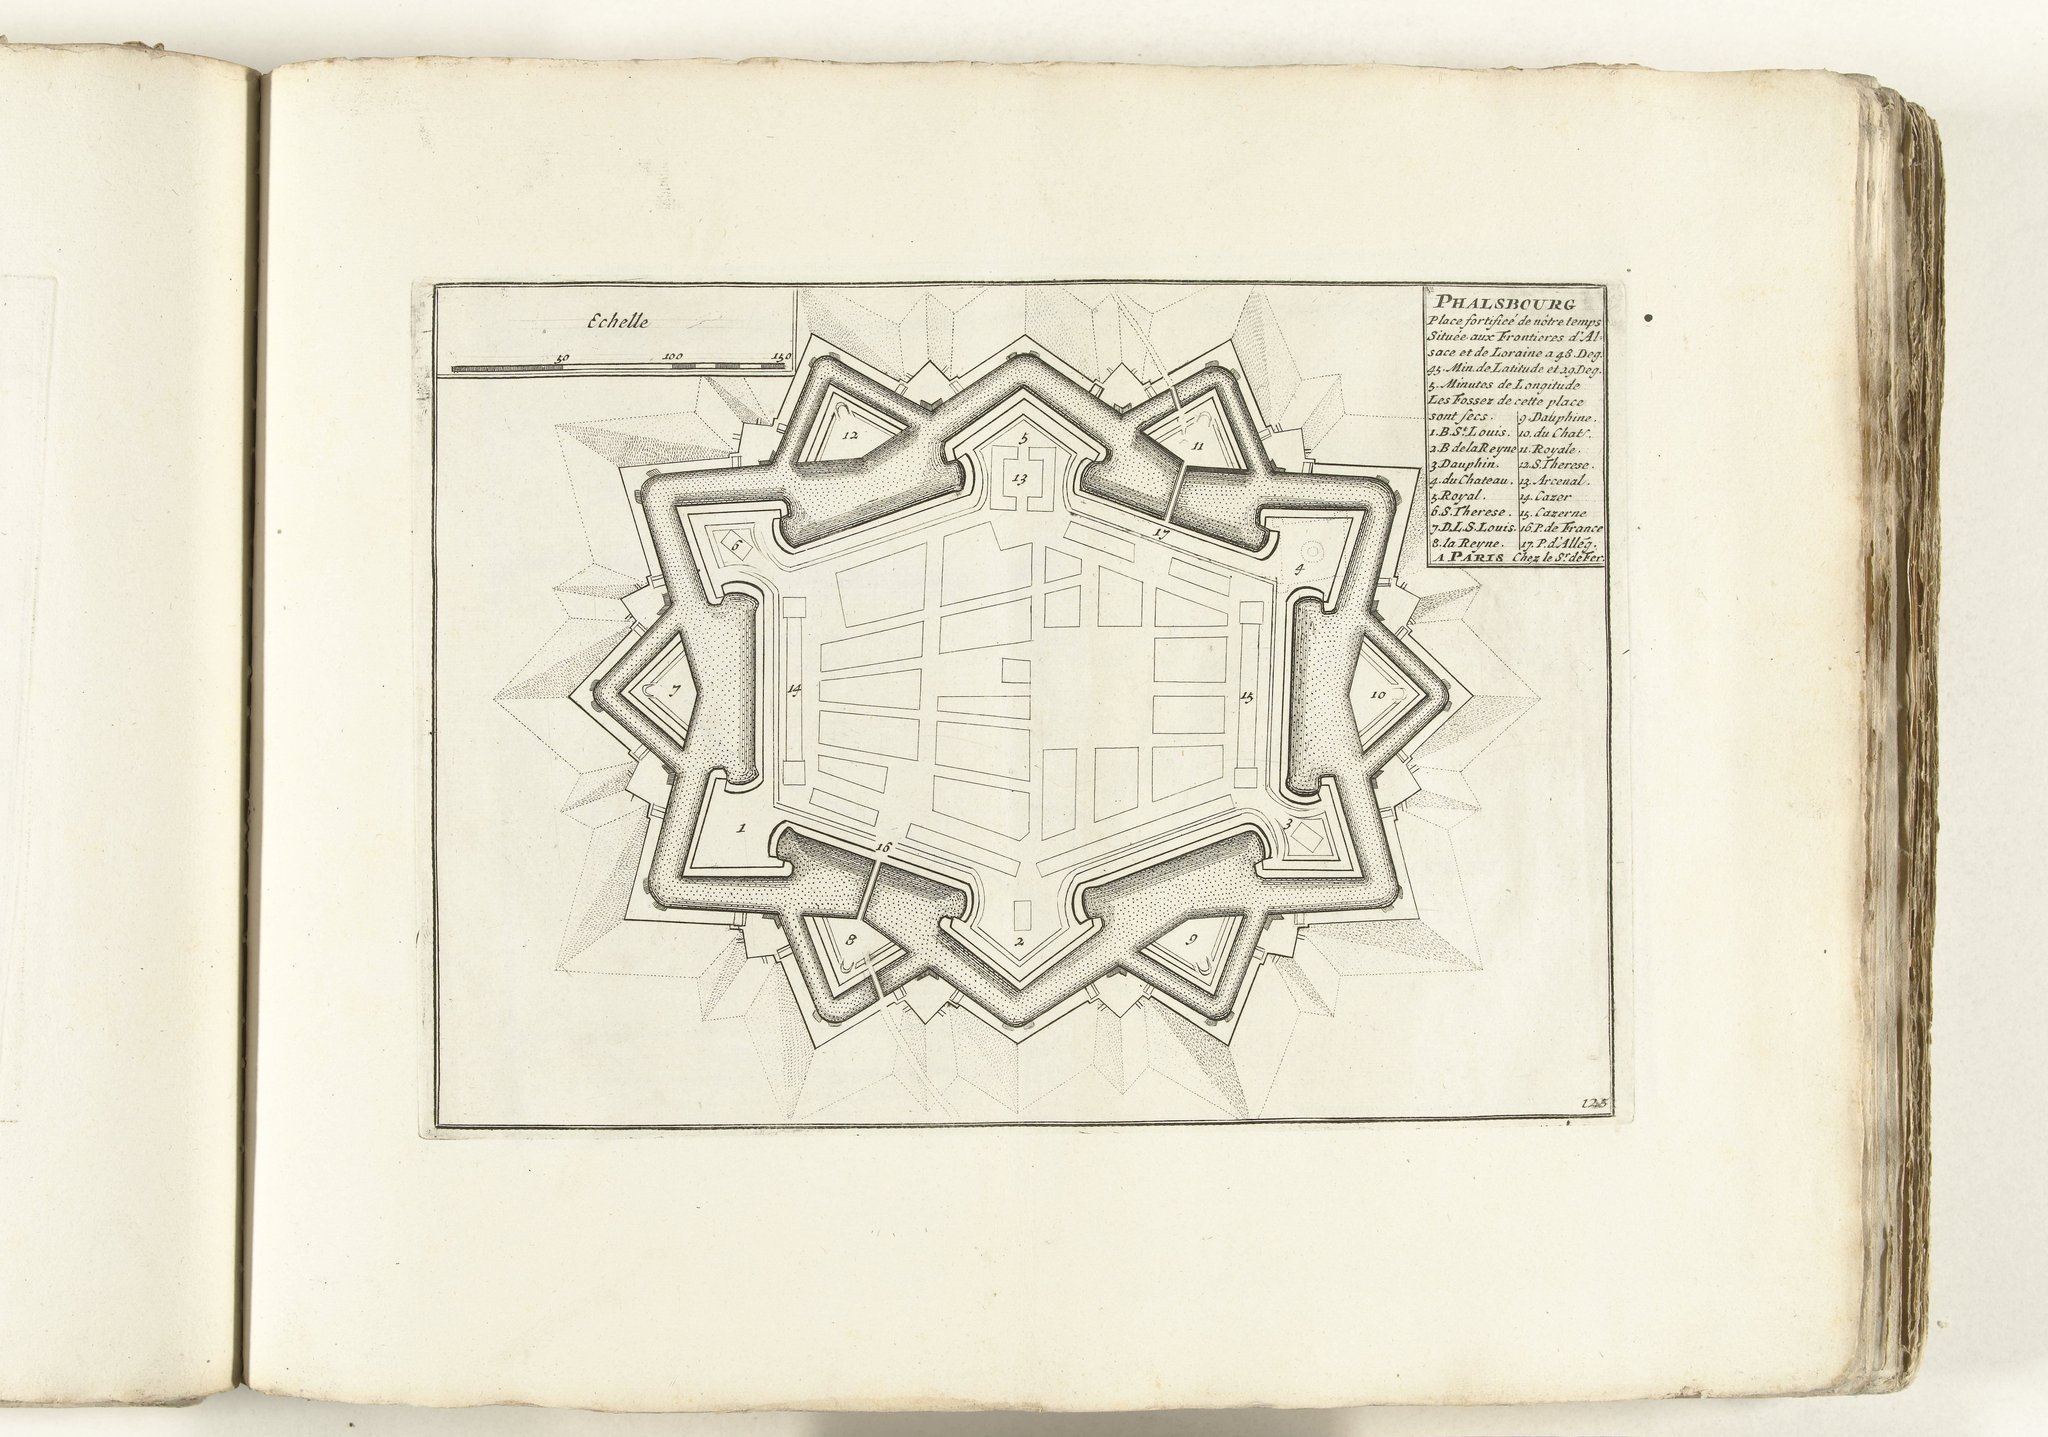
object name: print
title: Phalsbourg Place fortifiée de notre temps (...)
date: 1702-1703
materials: paper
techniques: etching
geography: northern netherlands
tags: fortress, maps of cities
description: Plattegrond van de versterkingen om de stad Phalsbourg. Plaat nr. 125 in het prentwerk bestaande in totaal uit 276 genummerde platen van vermaarde sterke steden en vestingen in het kader van de Spaanse Successieoorlog. Voor het merendeel zijn deze platen gekopieerd naar de anonieme Franse platen: in Les forces de l'Europe en in: Le theatre de la guerre, dans les Pays-Bas, beide oorspronkelijk uitgegeven door Nicolas de Fer te Parijs (1693-1697) in het kader van de Negenjarige Oorlog. Titel en opschriften in de plaat in het Frans.